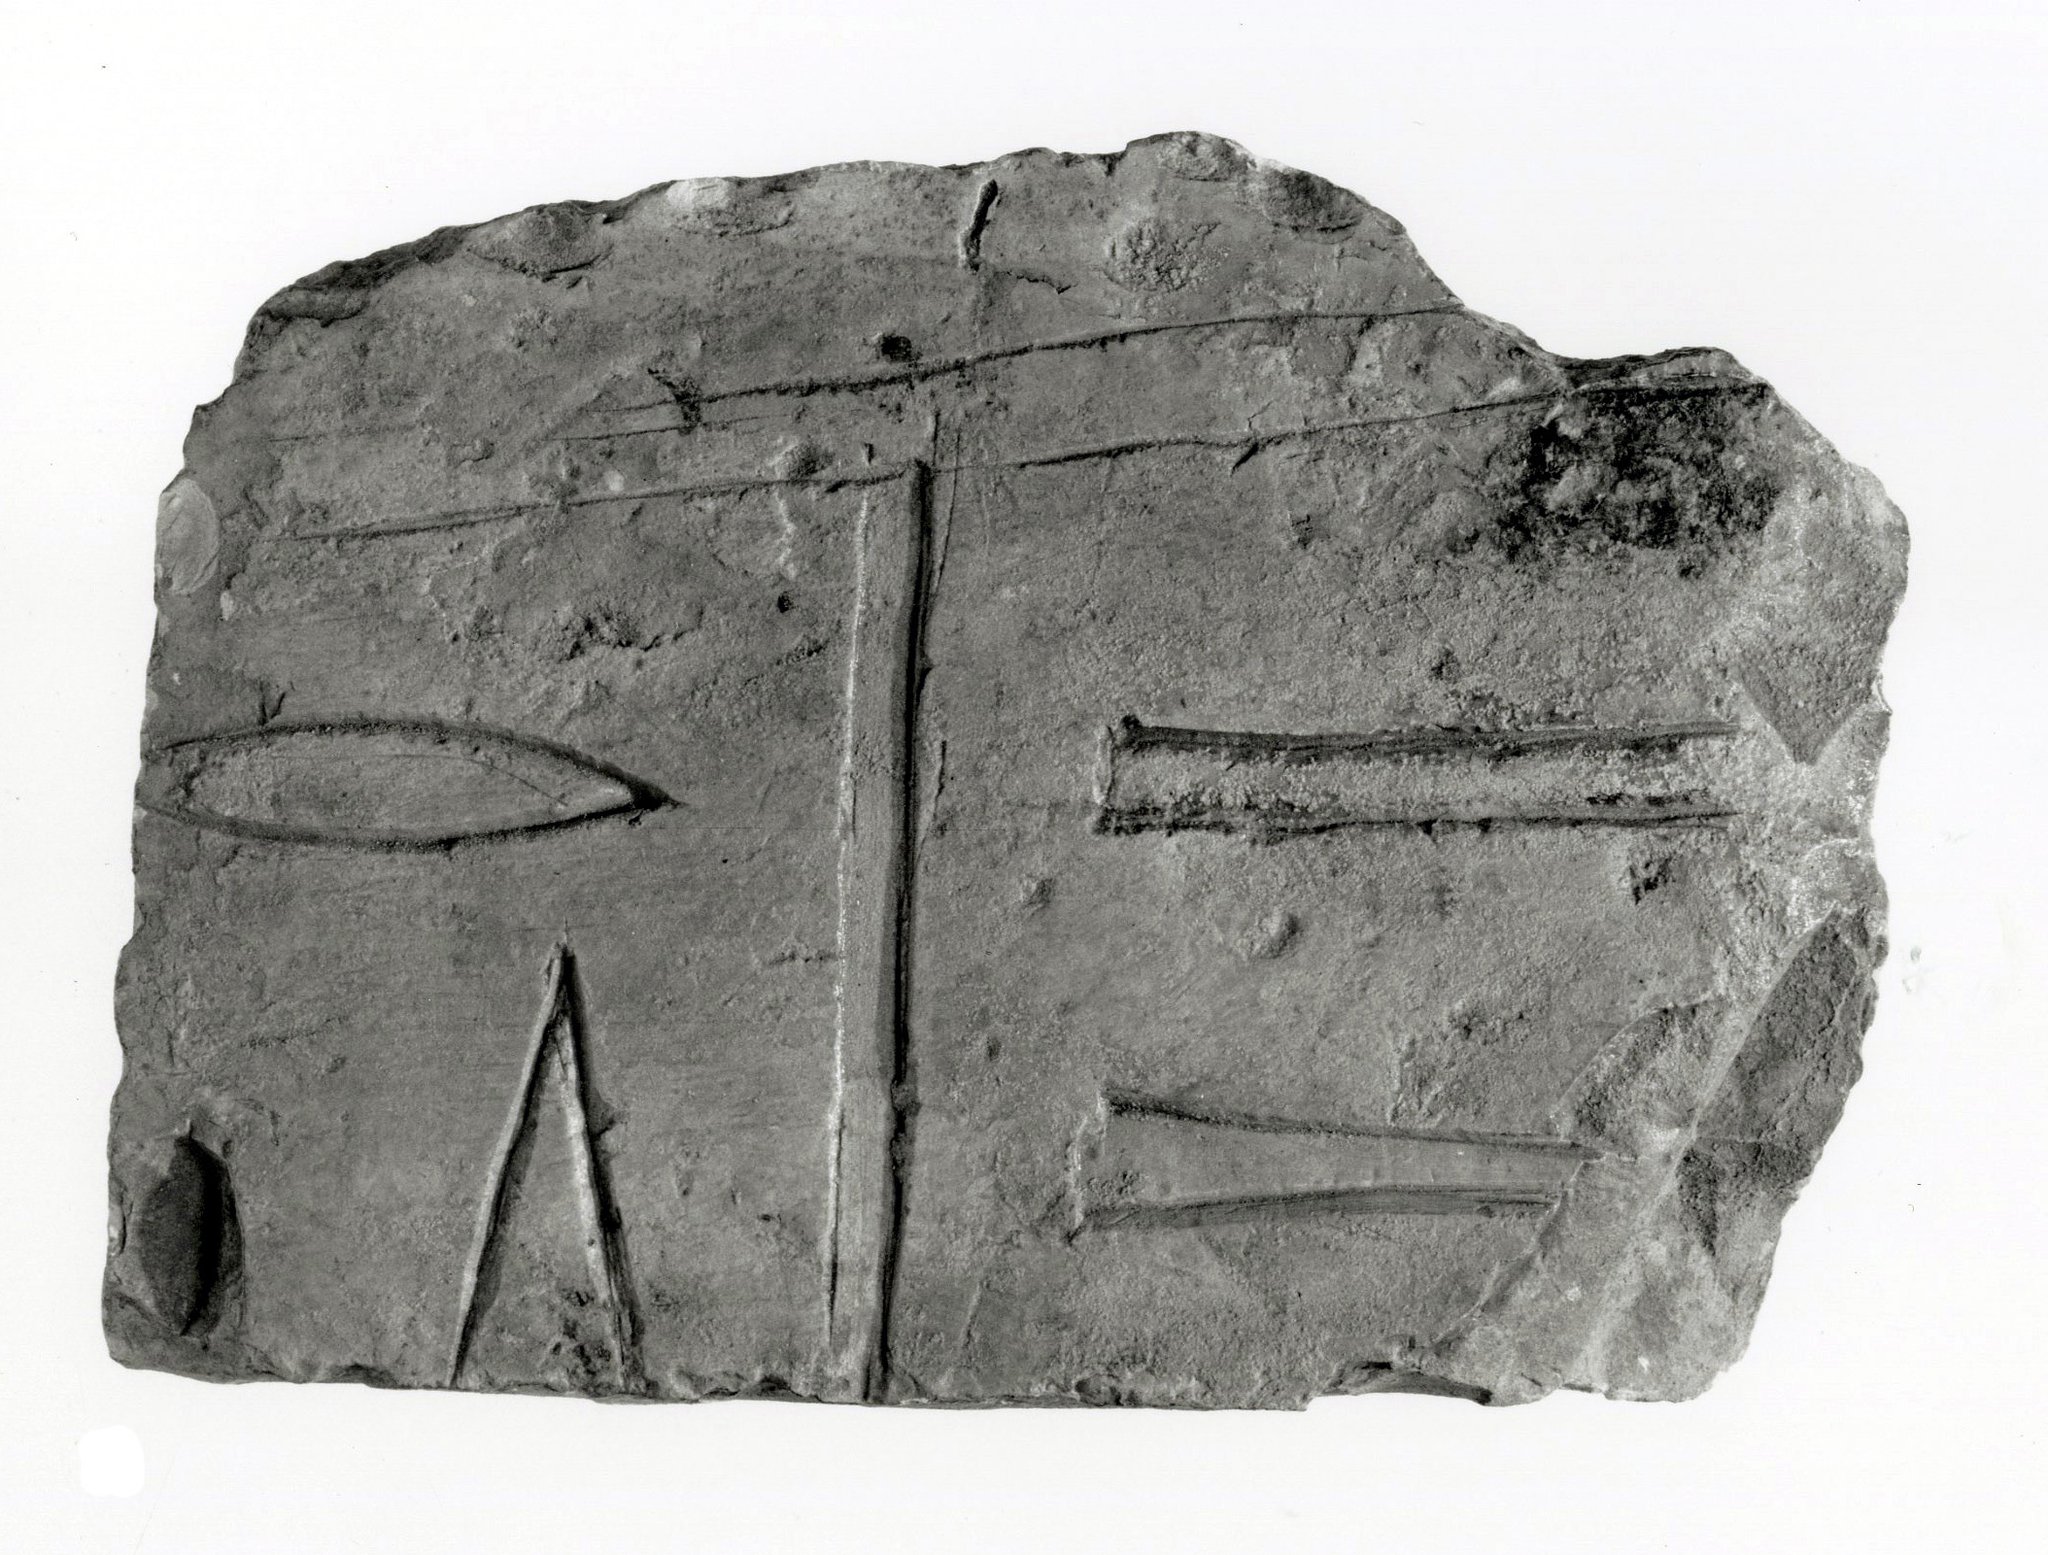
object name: relief, tomb of nespekashuty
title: Sunk Relief Fragment with Part of Offering Inscription and Wadjet Eye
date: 664-610 BCE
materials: limestone, varnish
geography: egypt